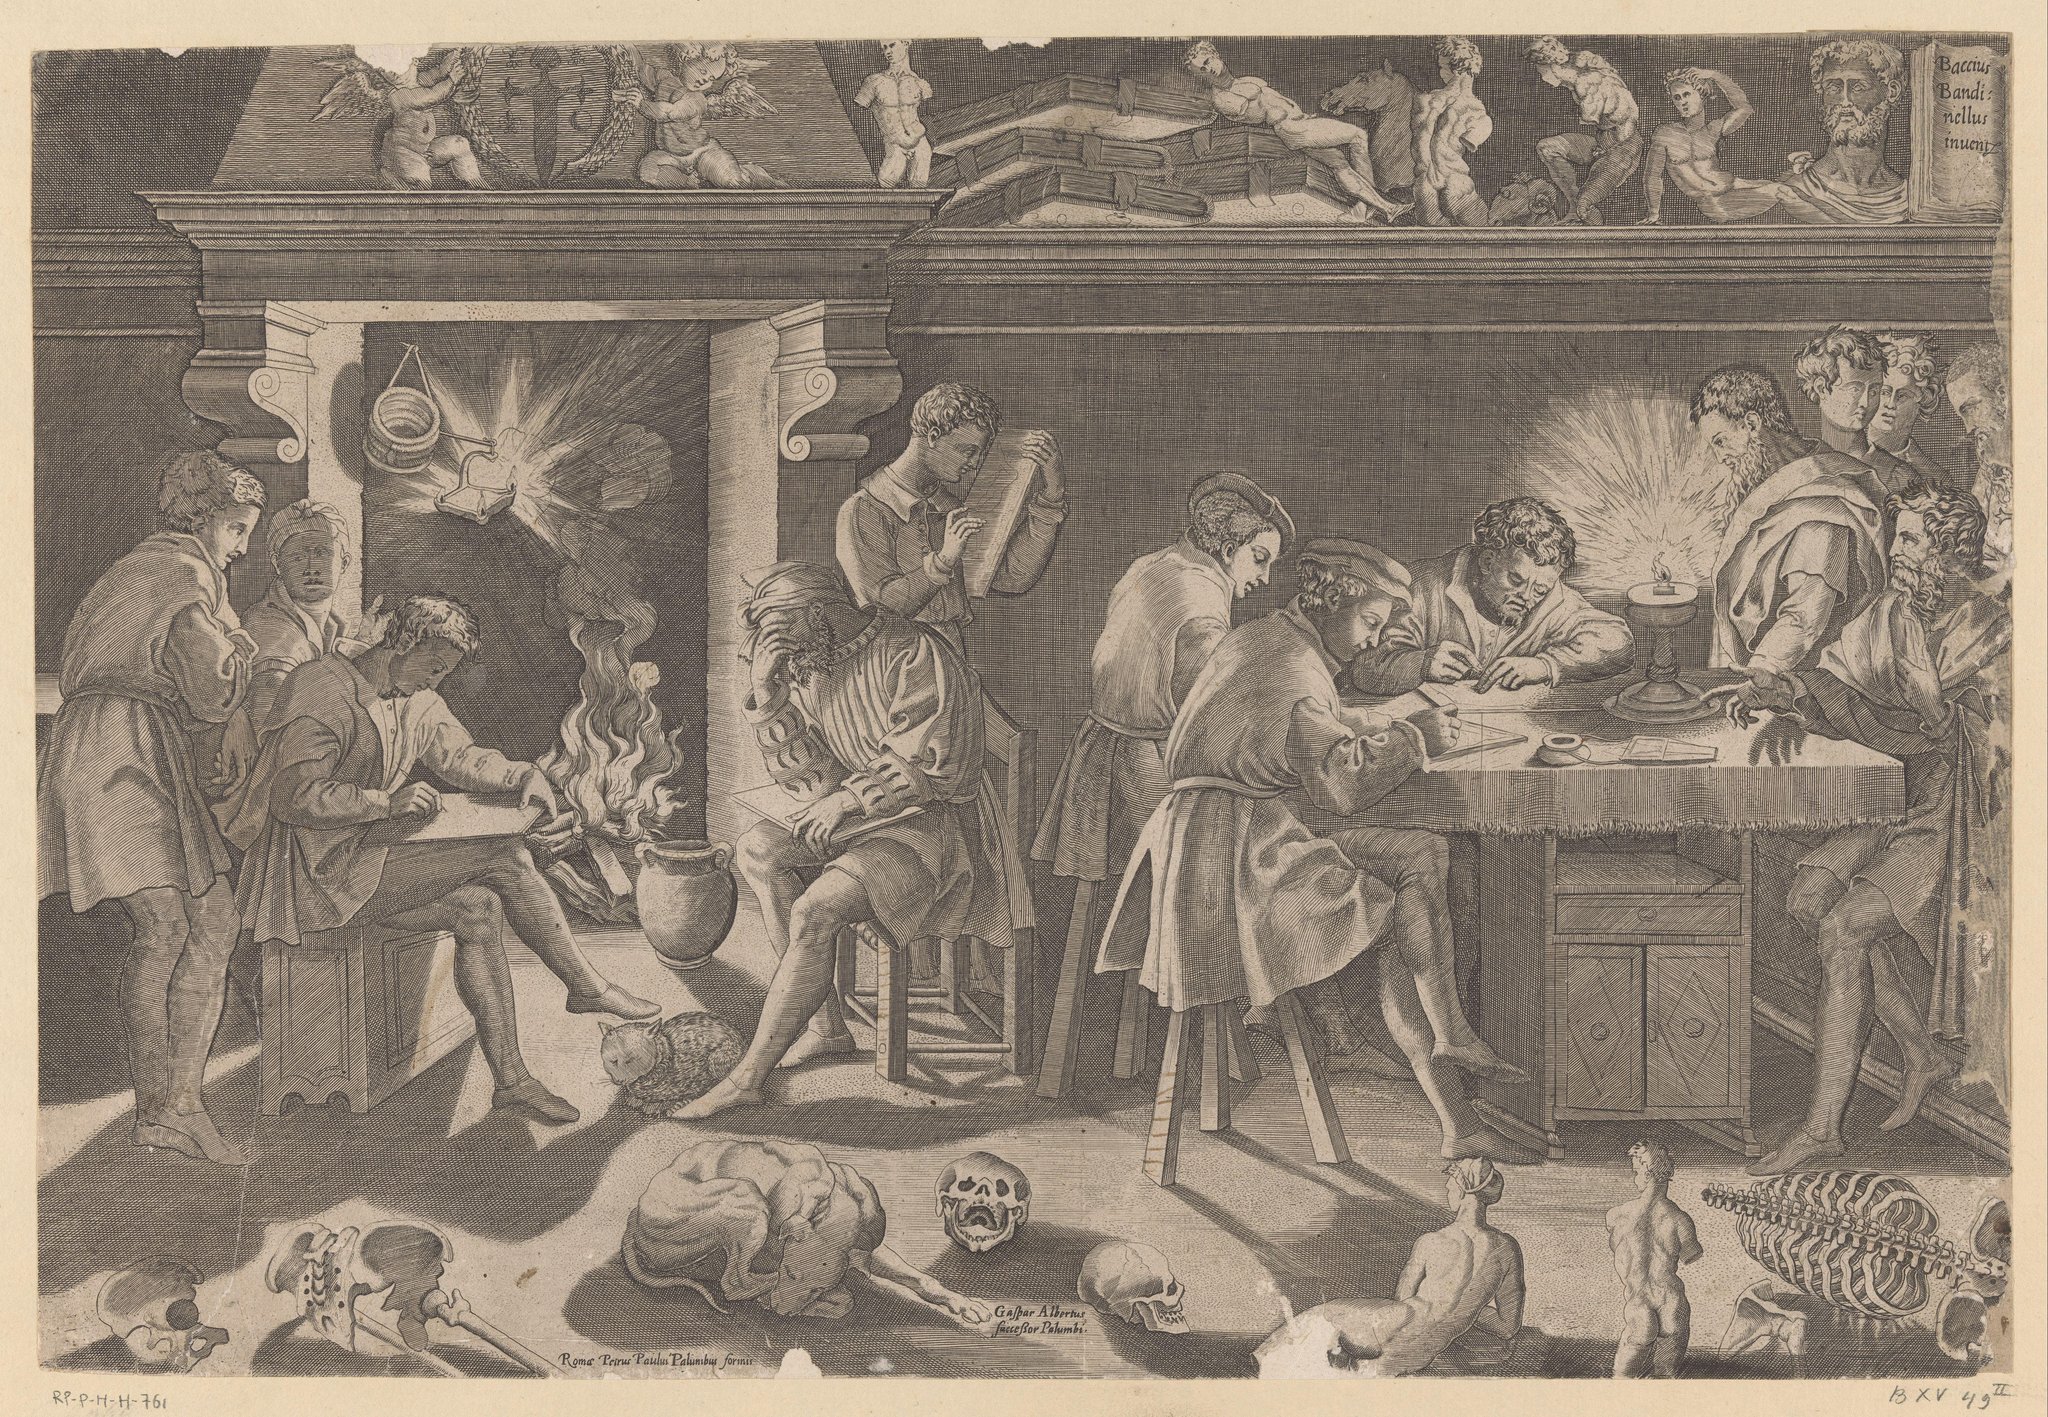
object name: print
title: Academie van beeldhouwer Baccio Bandinelli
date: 1533-1567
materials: paper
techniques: engraving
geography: italy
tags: baccio bandinelli, piece of sculpture, reproduction of a piece of sculpture, candle, student, draughtsman studying classical remains, place or institution of education and training of the artist, e.g.: academy of art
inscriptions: collector's mark: ‘Hinloopen’, collector's mark: Lugt 11, collector's mark: Lugt 10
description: Toegewijde nachtelijke studie met het accent op het tekenen is ook in de tweede prent van de 'Academia' van Bandinelli het centrale thema. Het studiemateriaal is hier echter uitgebreider: naast de sculptuur zijn er beenderen, skeletten en boeken aanwezig. Het tekenen naar skelet werd beschouwd als de enige manier om de menselijke figuur zonder fouten te kunnen afbeelden. De stapel boeken op de plank weerspiegelt het ideaal van de kunstenaar als geleerde. Geen van de figuren tekent naar model: ze zijn zó ver gevorderd dat ze nu in staat zijn uit het hoofd te tekenen naar hun eigen idee.